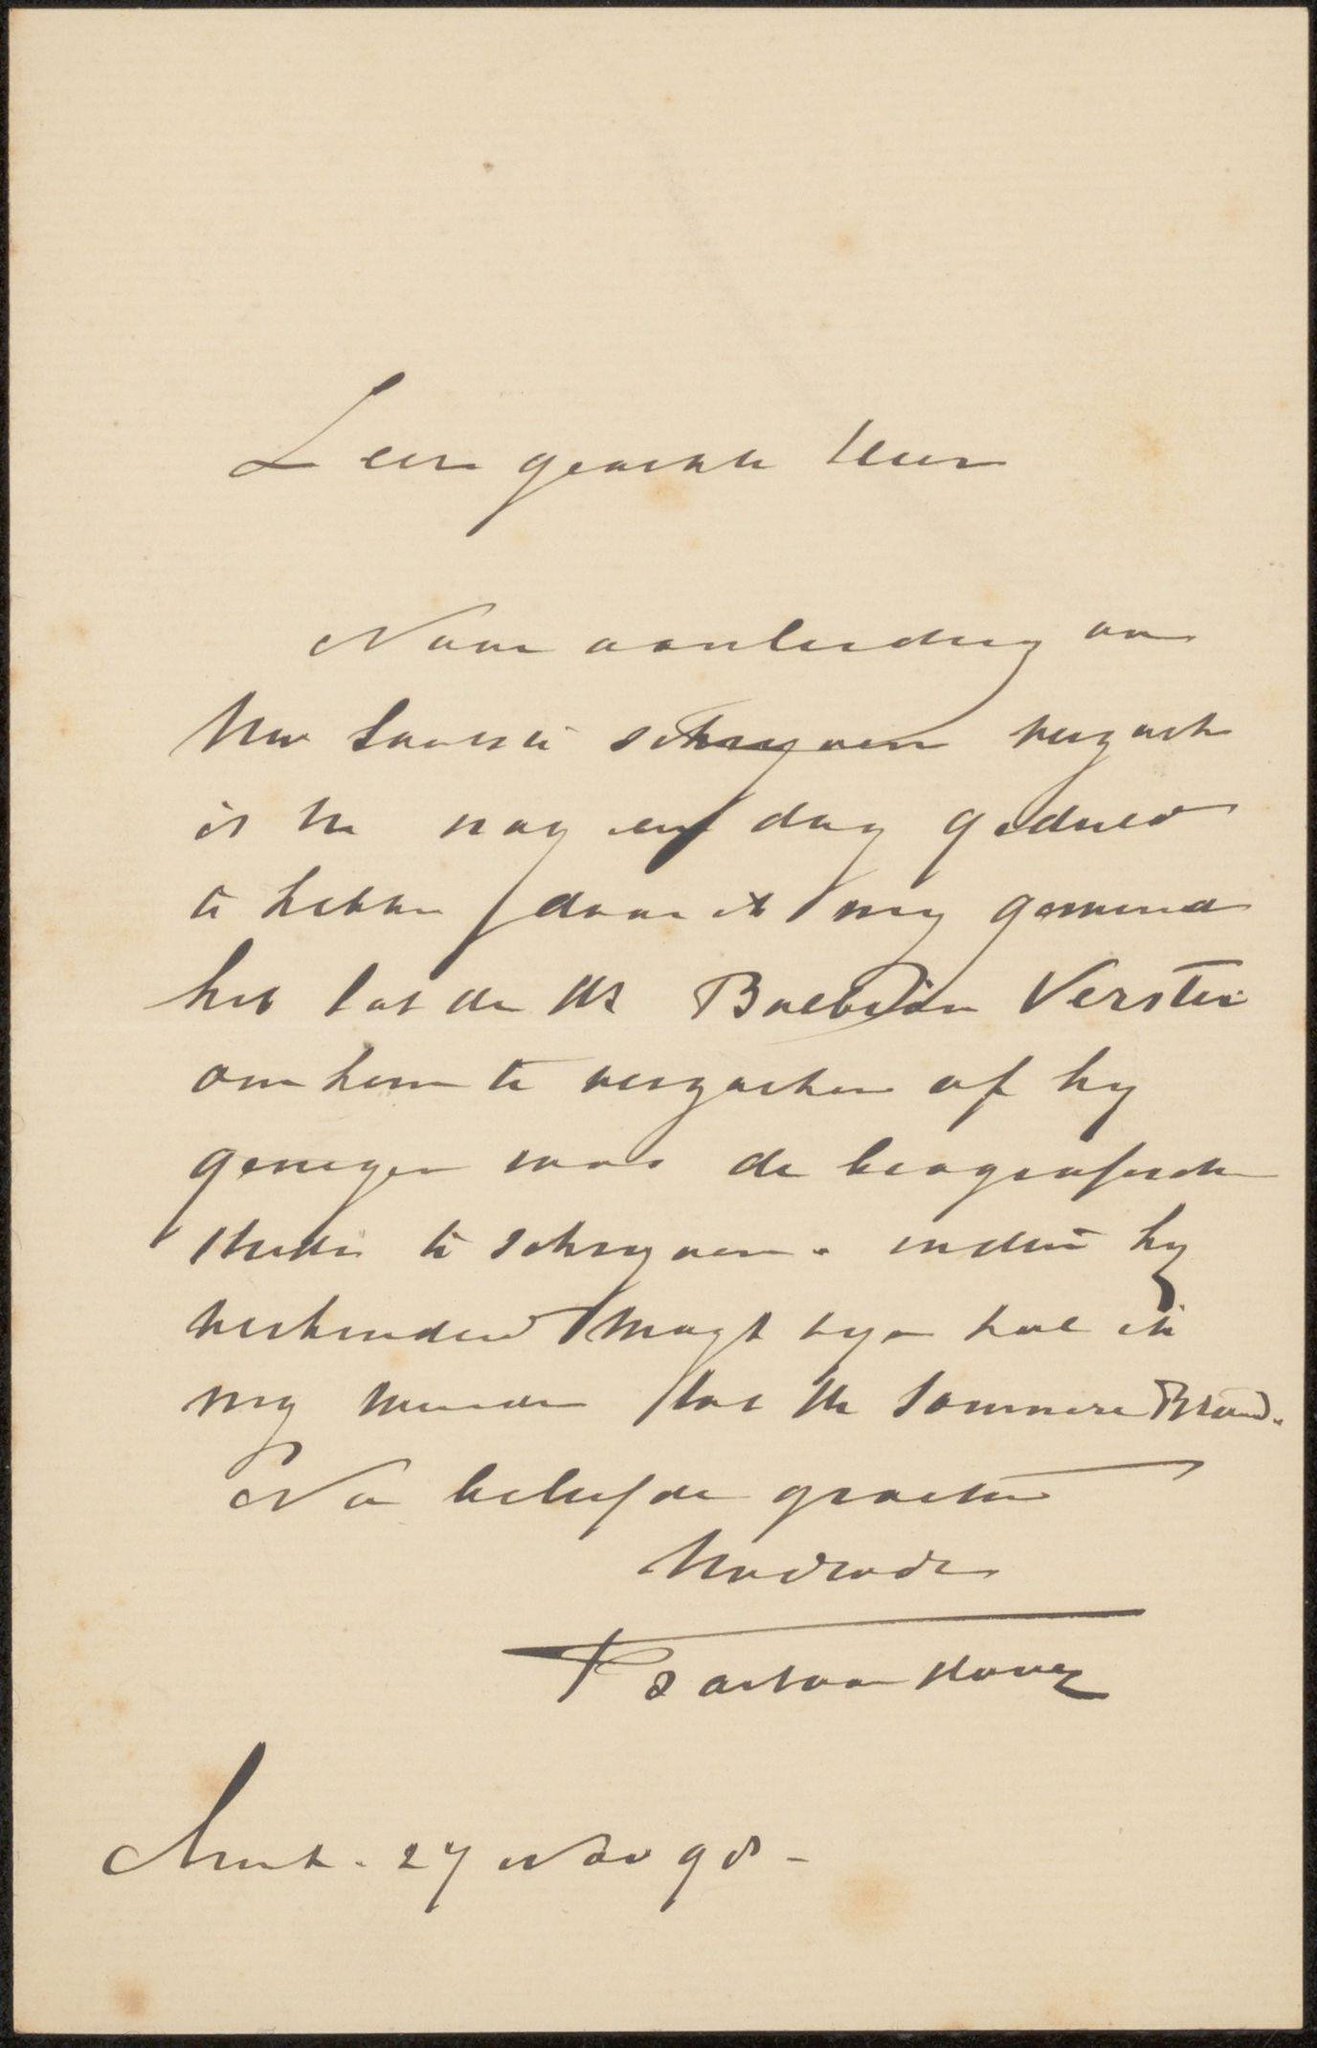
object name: letter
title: Brief aan Philip Zilcken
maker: bart van hove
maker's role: sculptor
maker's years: 1850-1914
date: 1898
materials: ink, paper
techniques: pen, writing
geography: amsterdam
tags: abraham henricus de balbian verster, the hague, draughtsman, philip zilcken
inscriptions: collector's mark: ‘RPK’